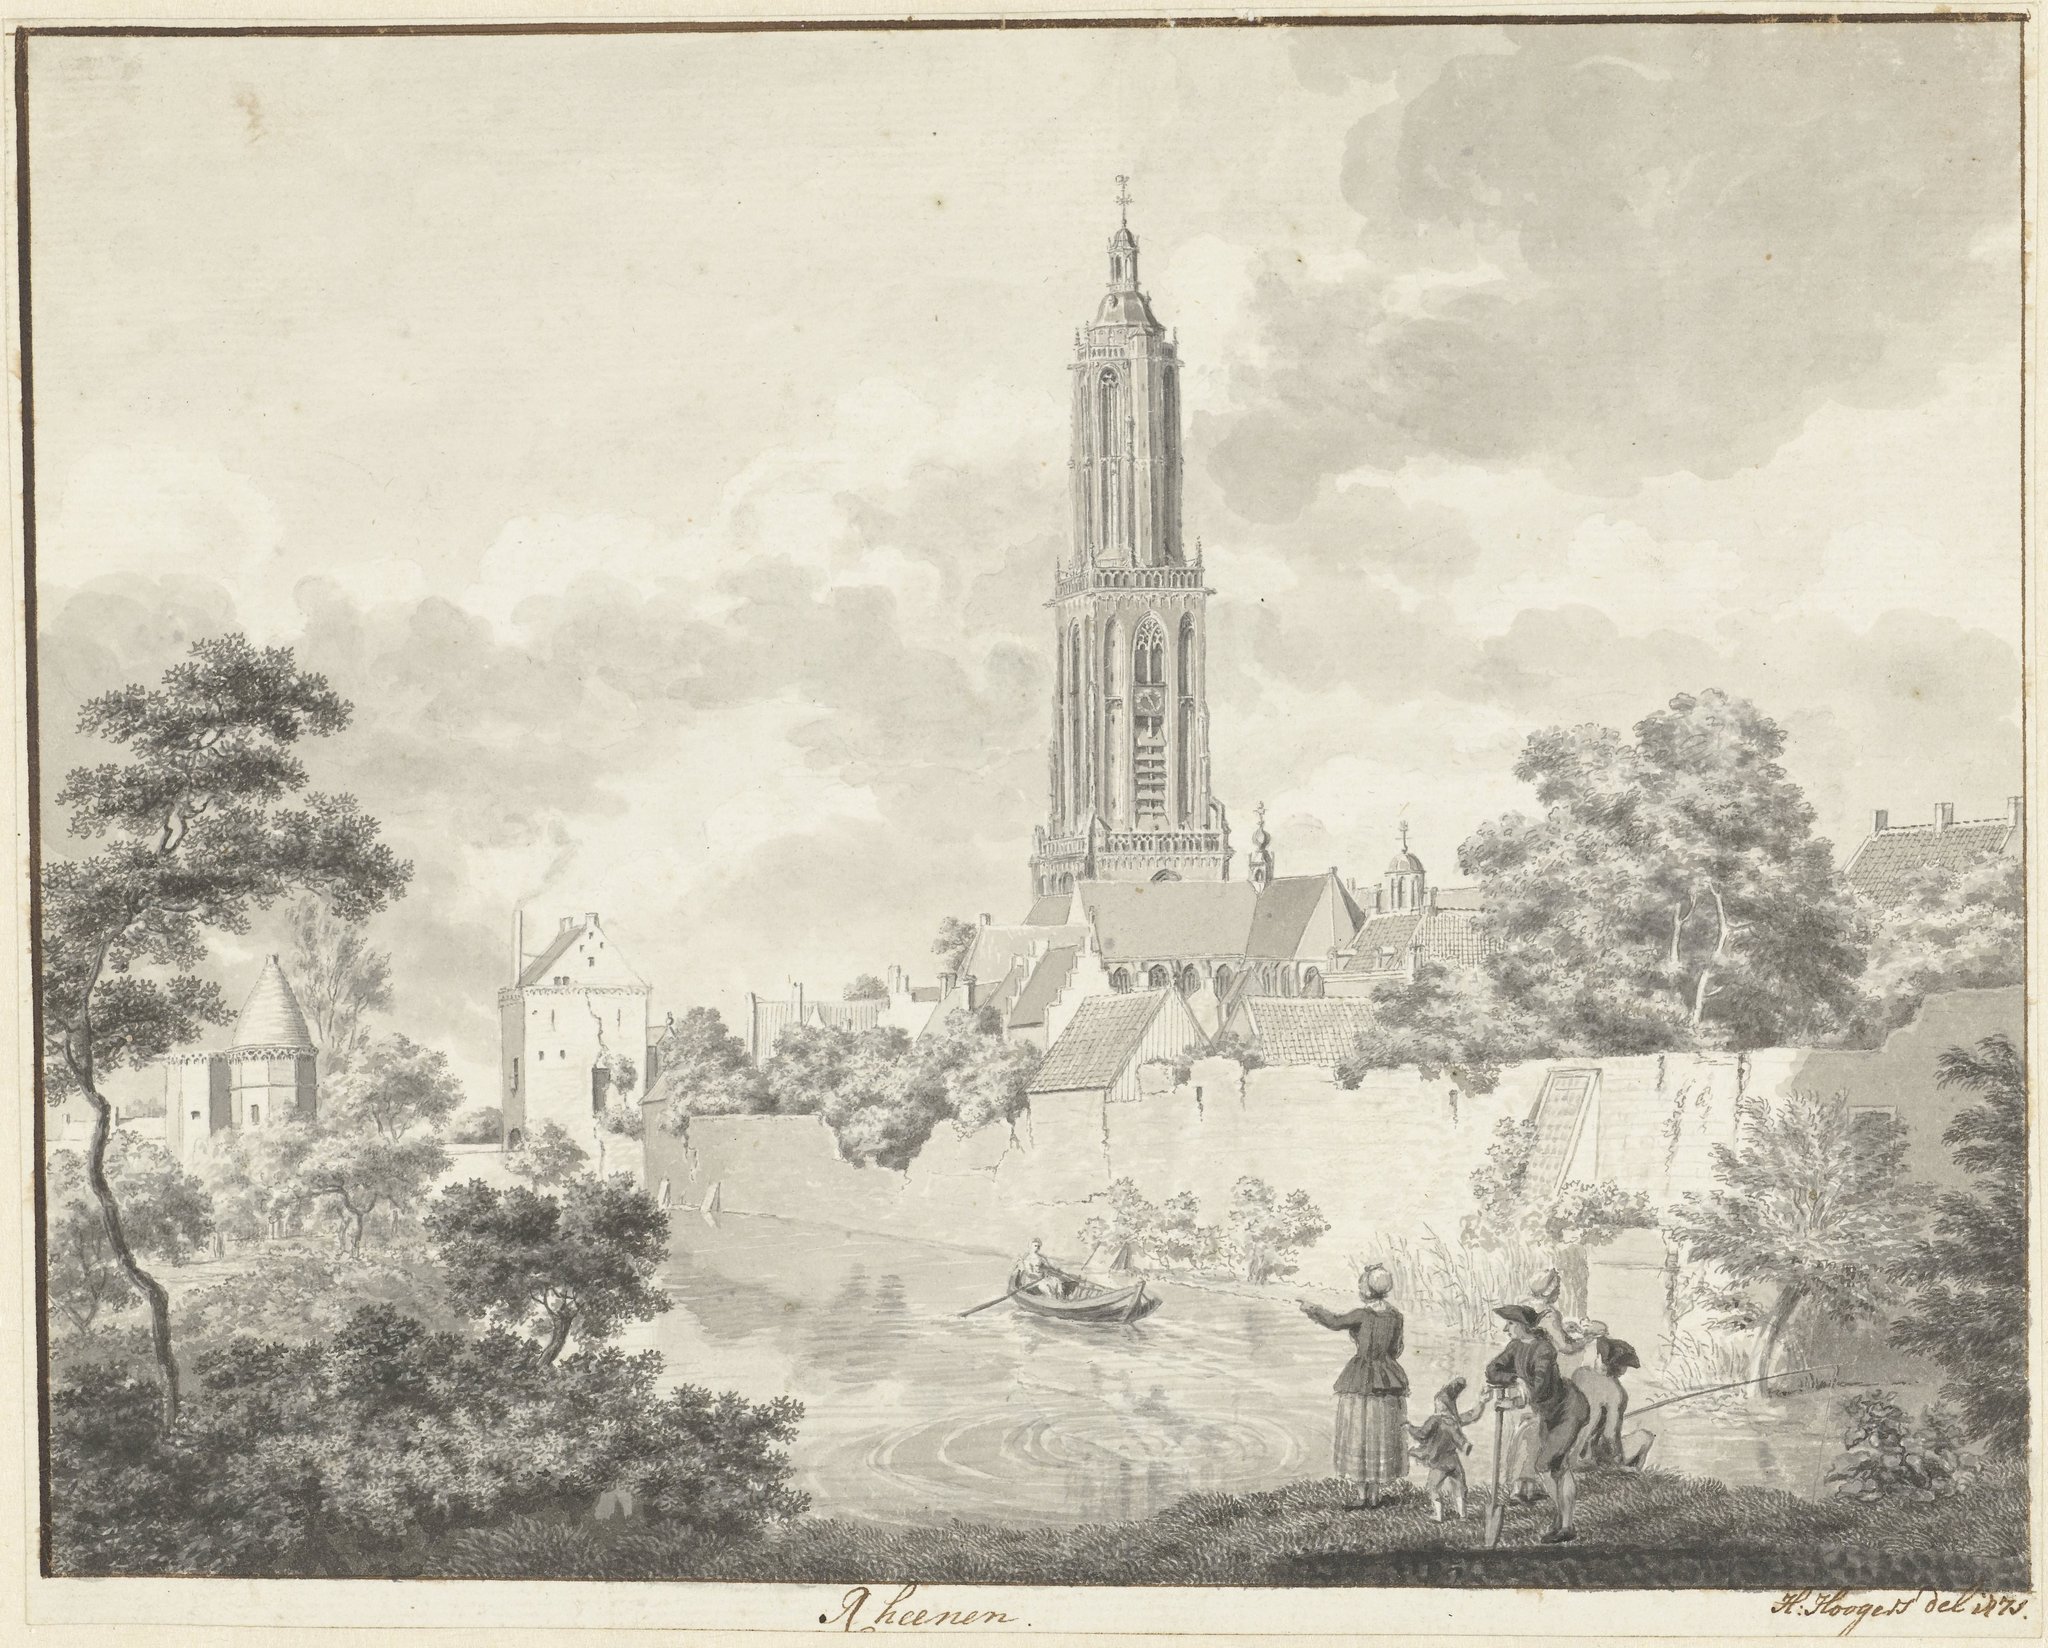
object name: drawing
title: Gezicht op Rhenen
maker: hendrik hoogers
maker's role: draughtsman, mayor, print maker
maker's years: 1747-1814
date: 1771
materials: ink, paper, pencil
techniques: brush, pen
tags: prospect of city, town panorama, silhouette of city, rhenen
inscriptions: date: ‘1771’